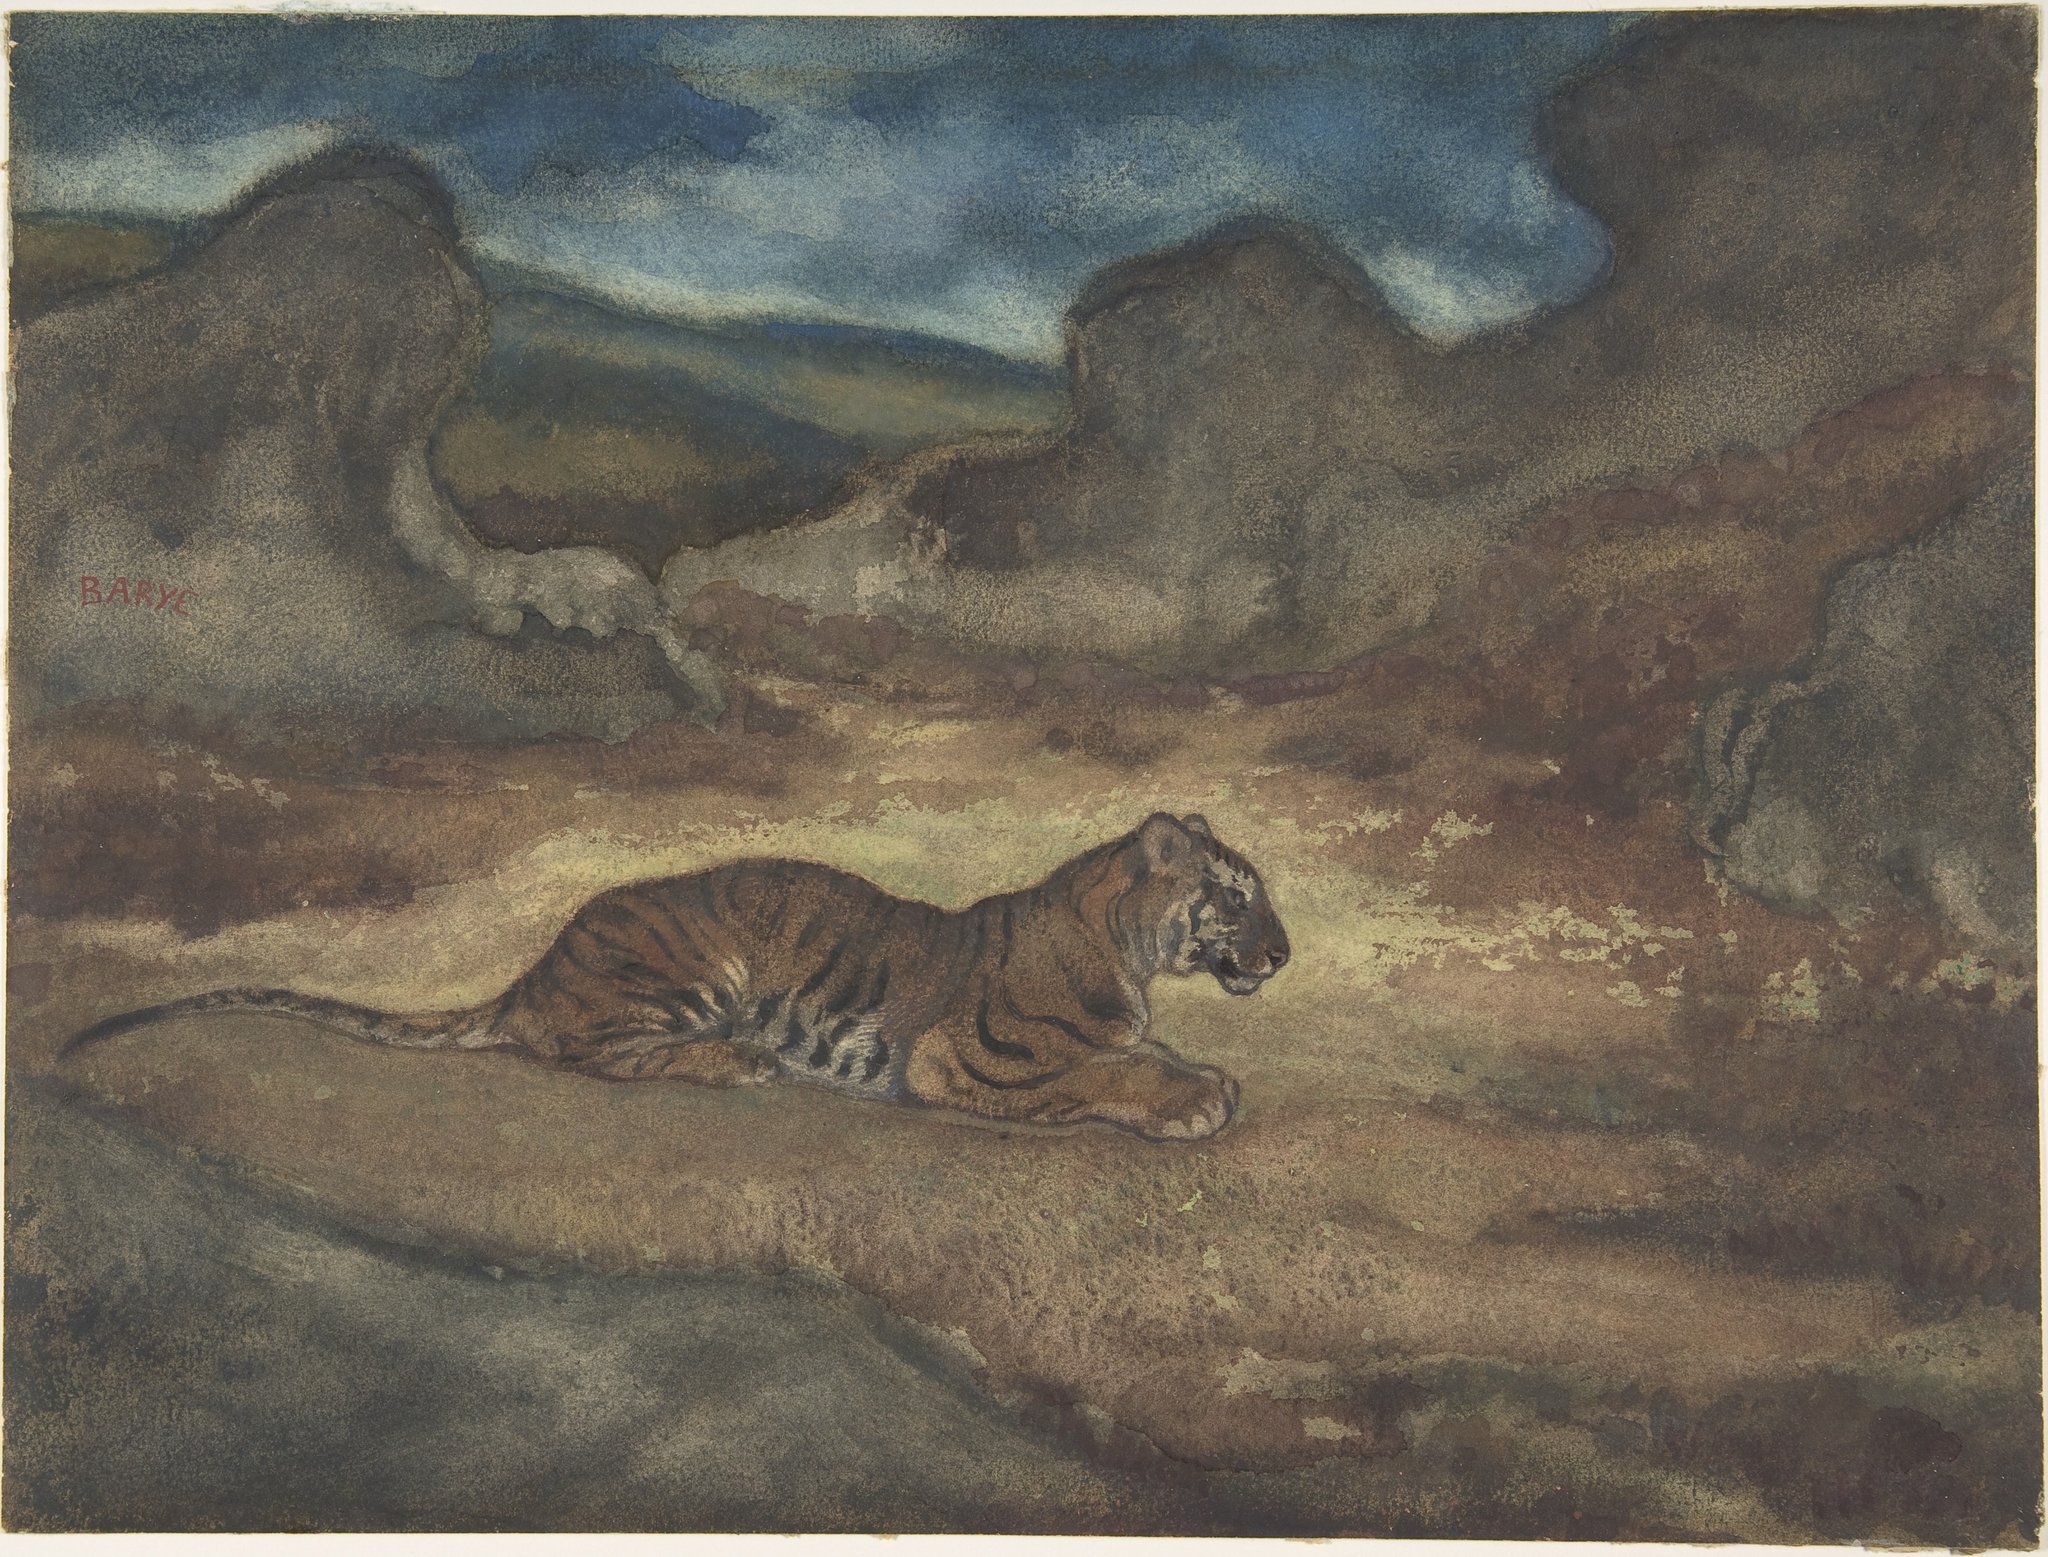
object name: drawing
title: Tiger in Landscape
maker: antoine-louis barye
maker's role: artist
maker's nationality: french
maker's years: 1795-1875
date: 1810-1875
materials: paper, watercolor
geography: france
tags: tigers